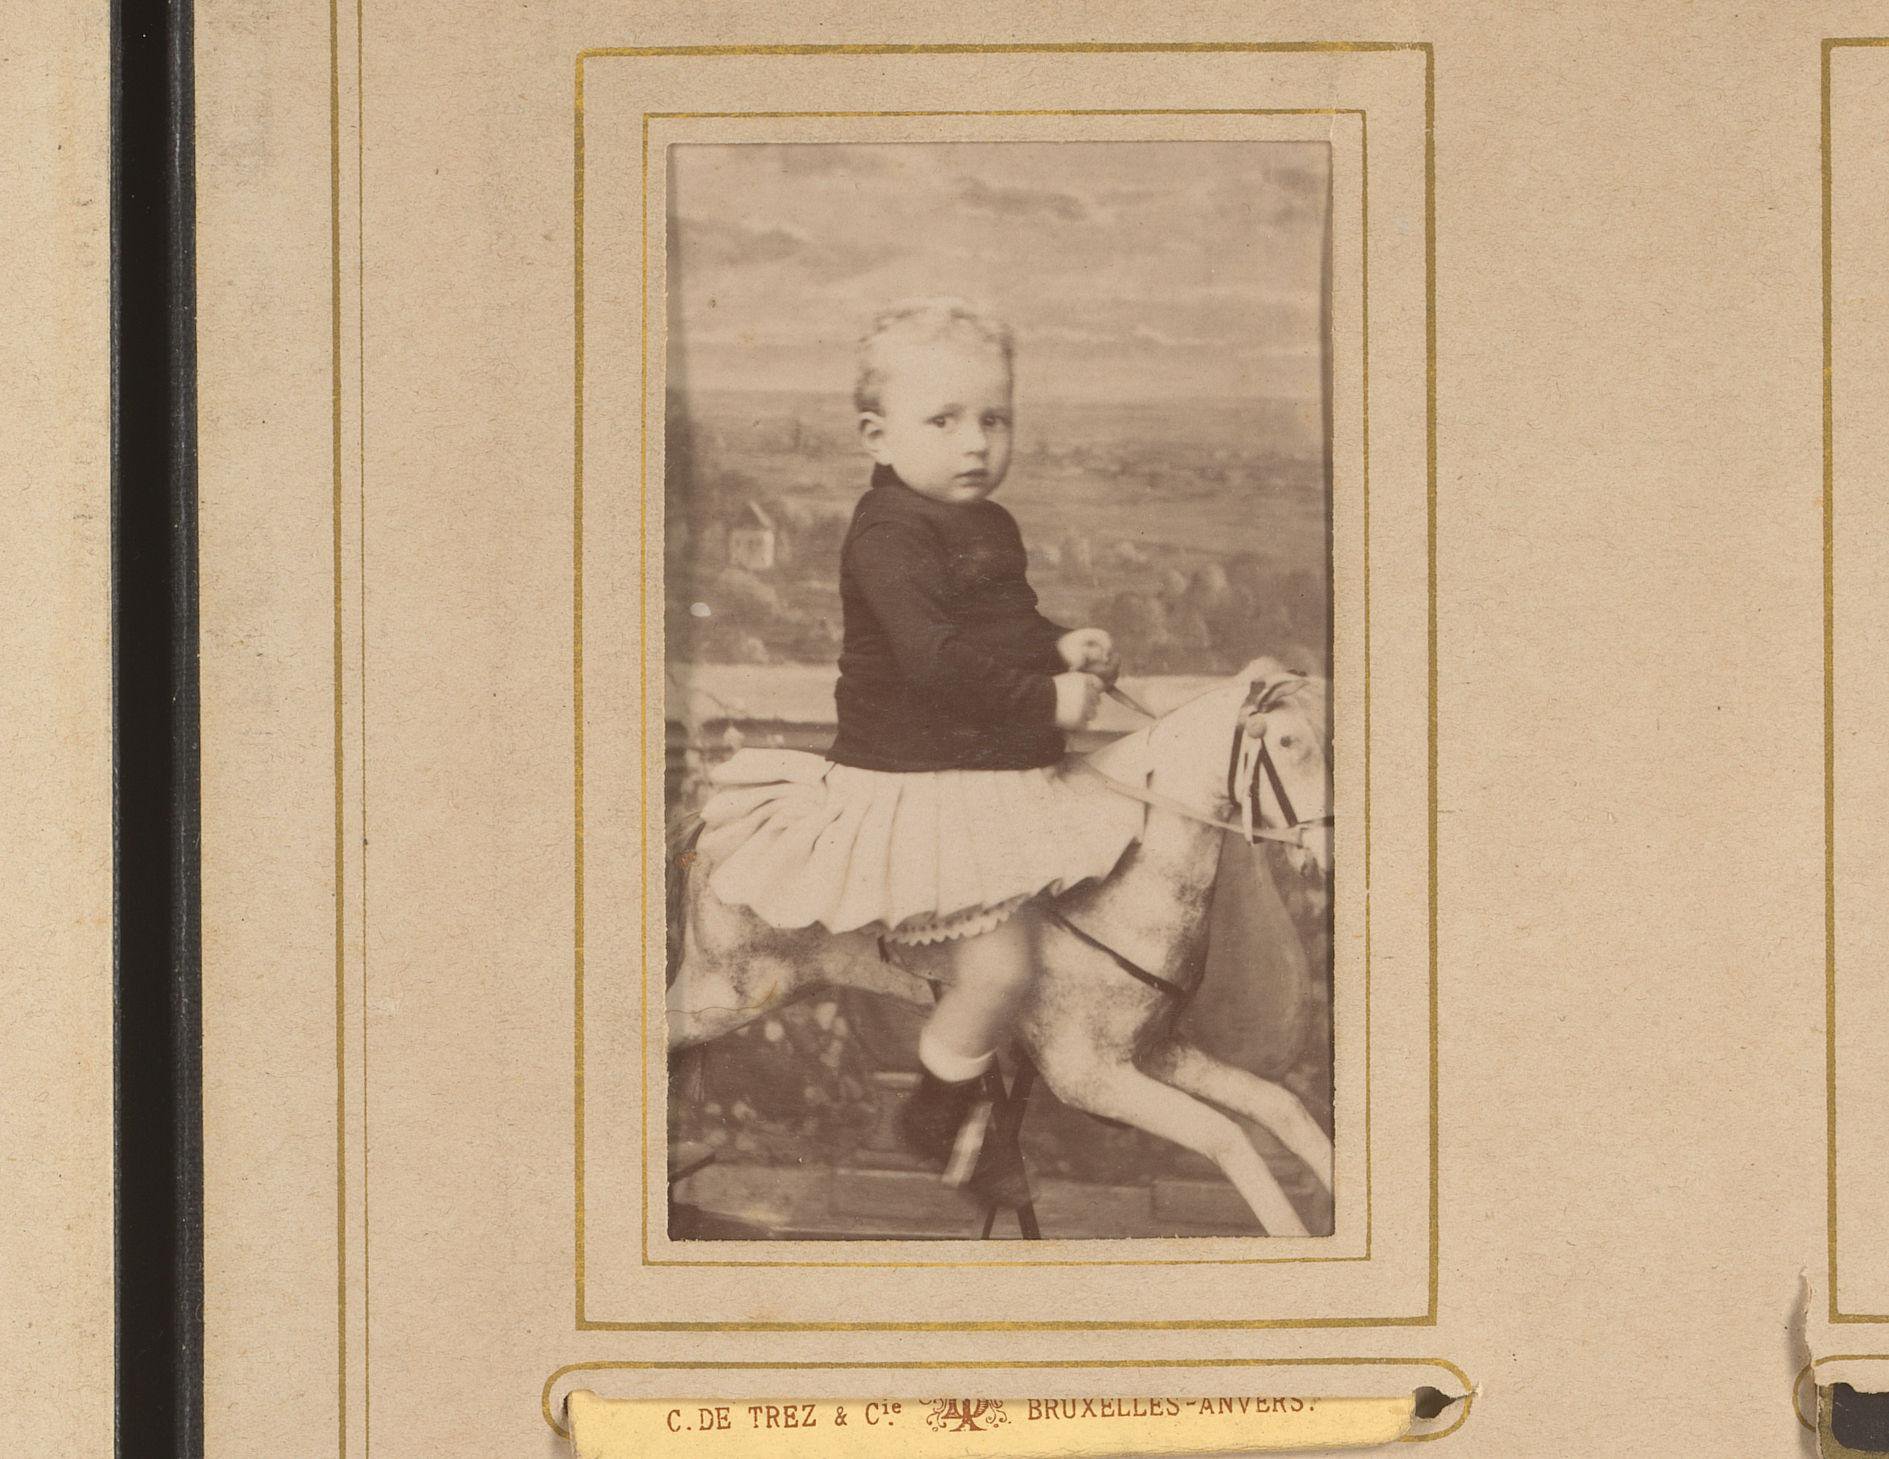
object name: carte de visite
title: Portret van een meisje op een hobbelpaard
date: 1885-1907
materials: cardboard, photographic support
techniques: albumen print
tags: historical persons, girl (child between toddler and youth), rocking-horse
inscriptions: inscription: ‘Photographie Perfectionnée/ Cte de Trez & Cie/ Maison a Bruxelles/ 1, Rue du Pont Neuf, 1 (...)’, name: ‘C. de Trez & Cie Bruxelles - Anvers’